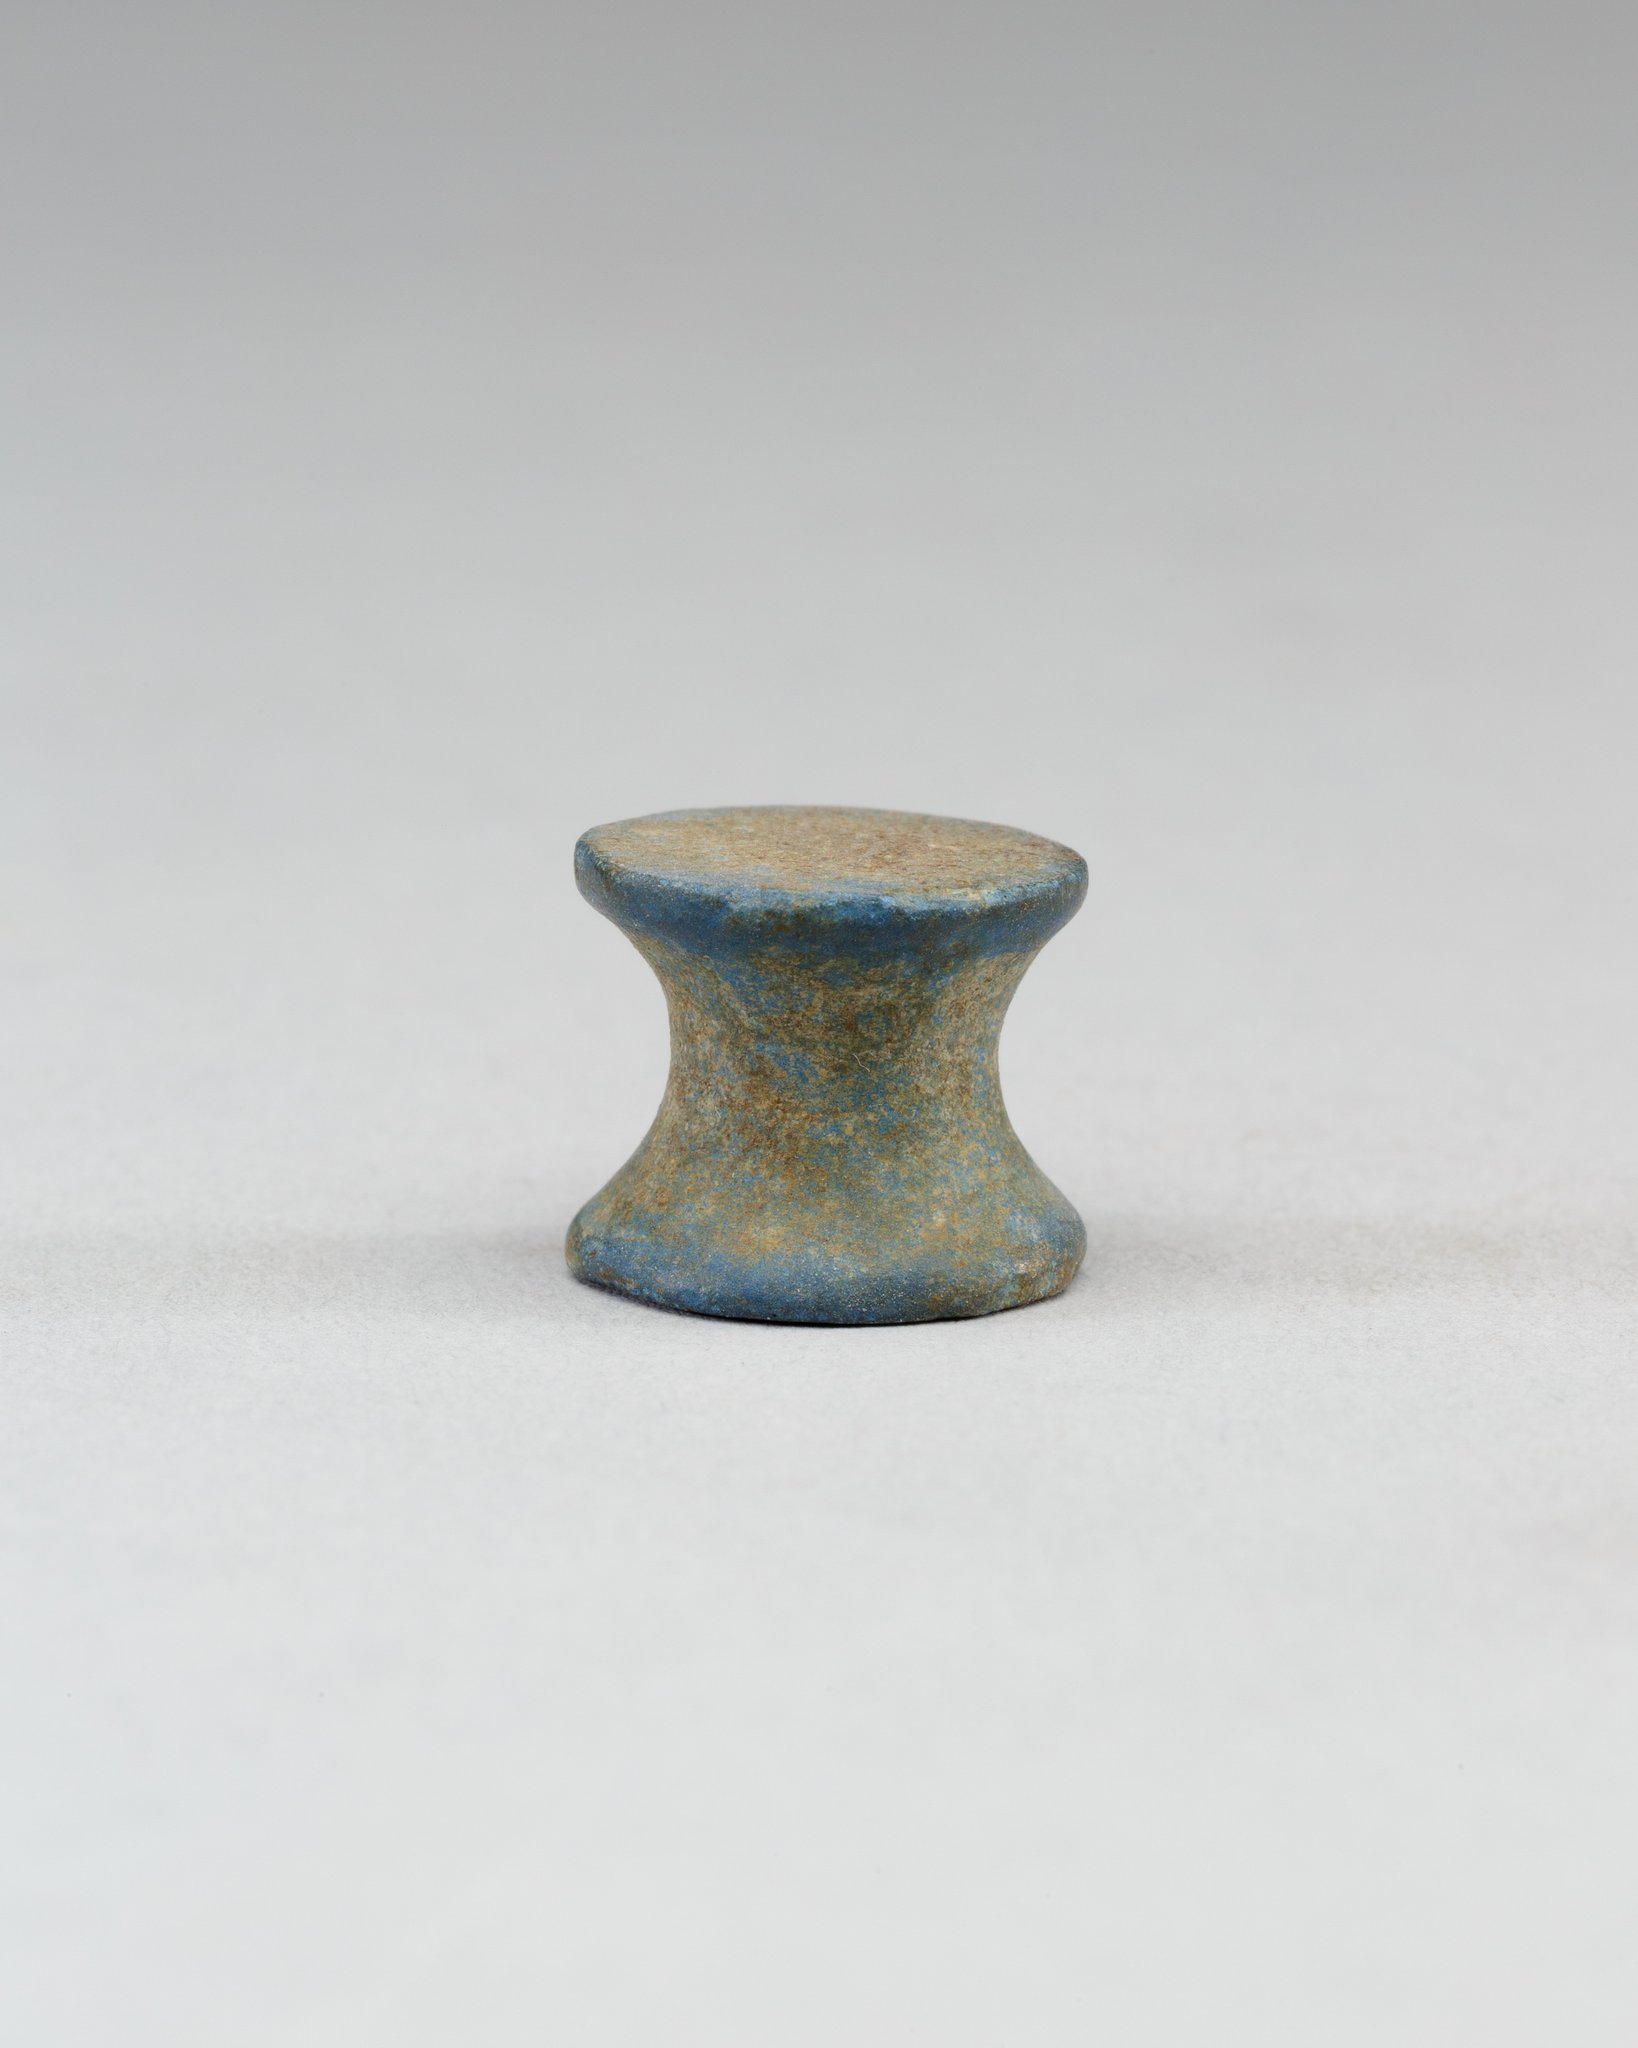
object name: game piece, spool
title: Spool-Shaped Game Piece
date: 1504-1447 BCE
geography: egypt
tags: games